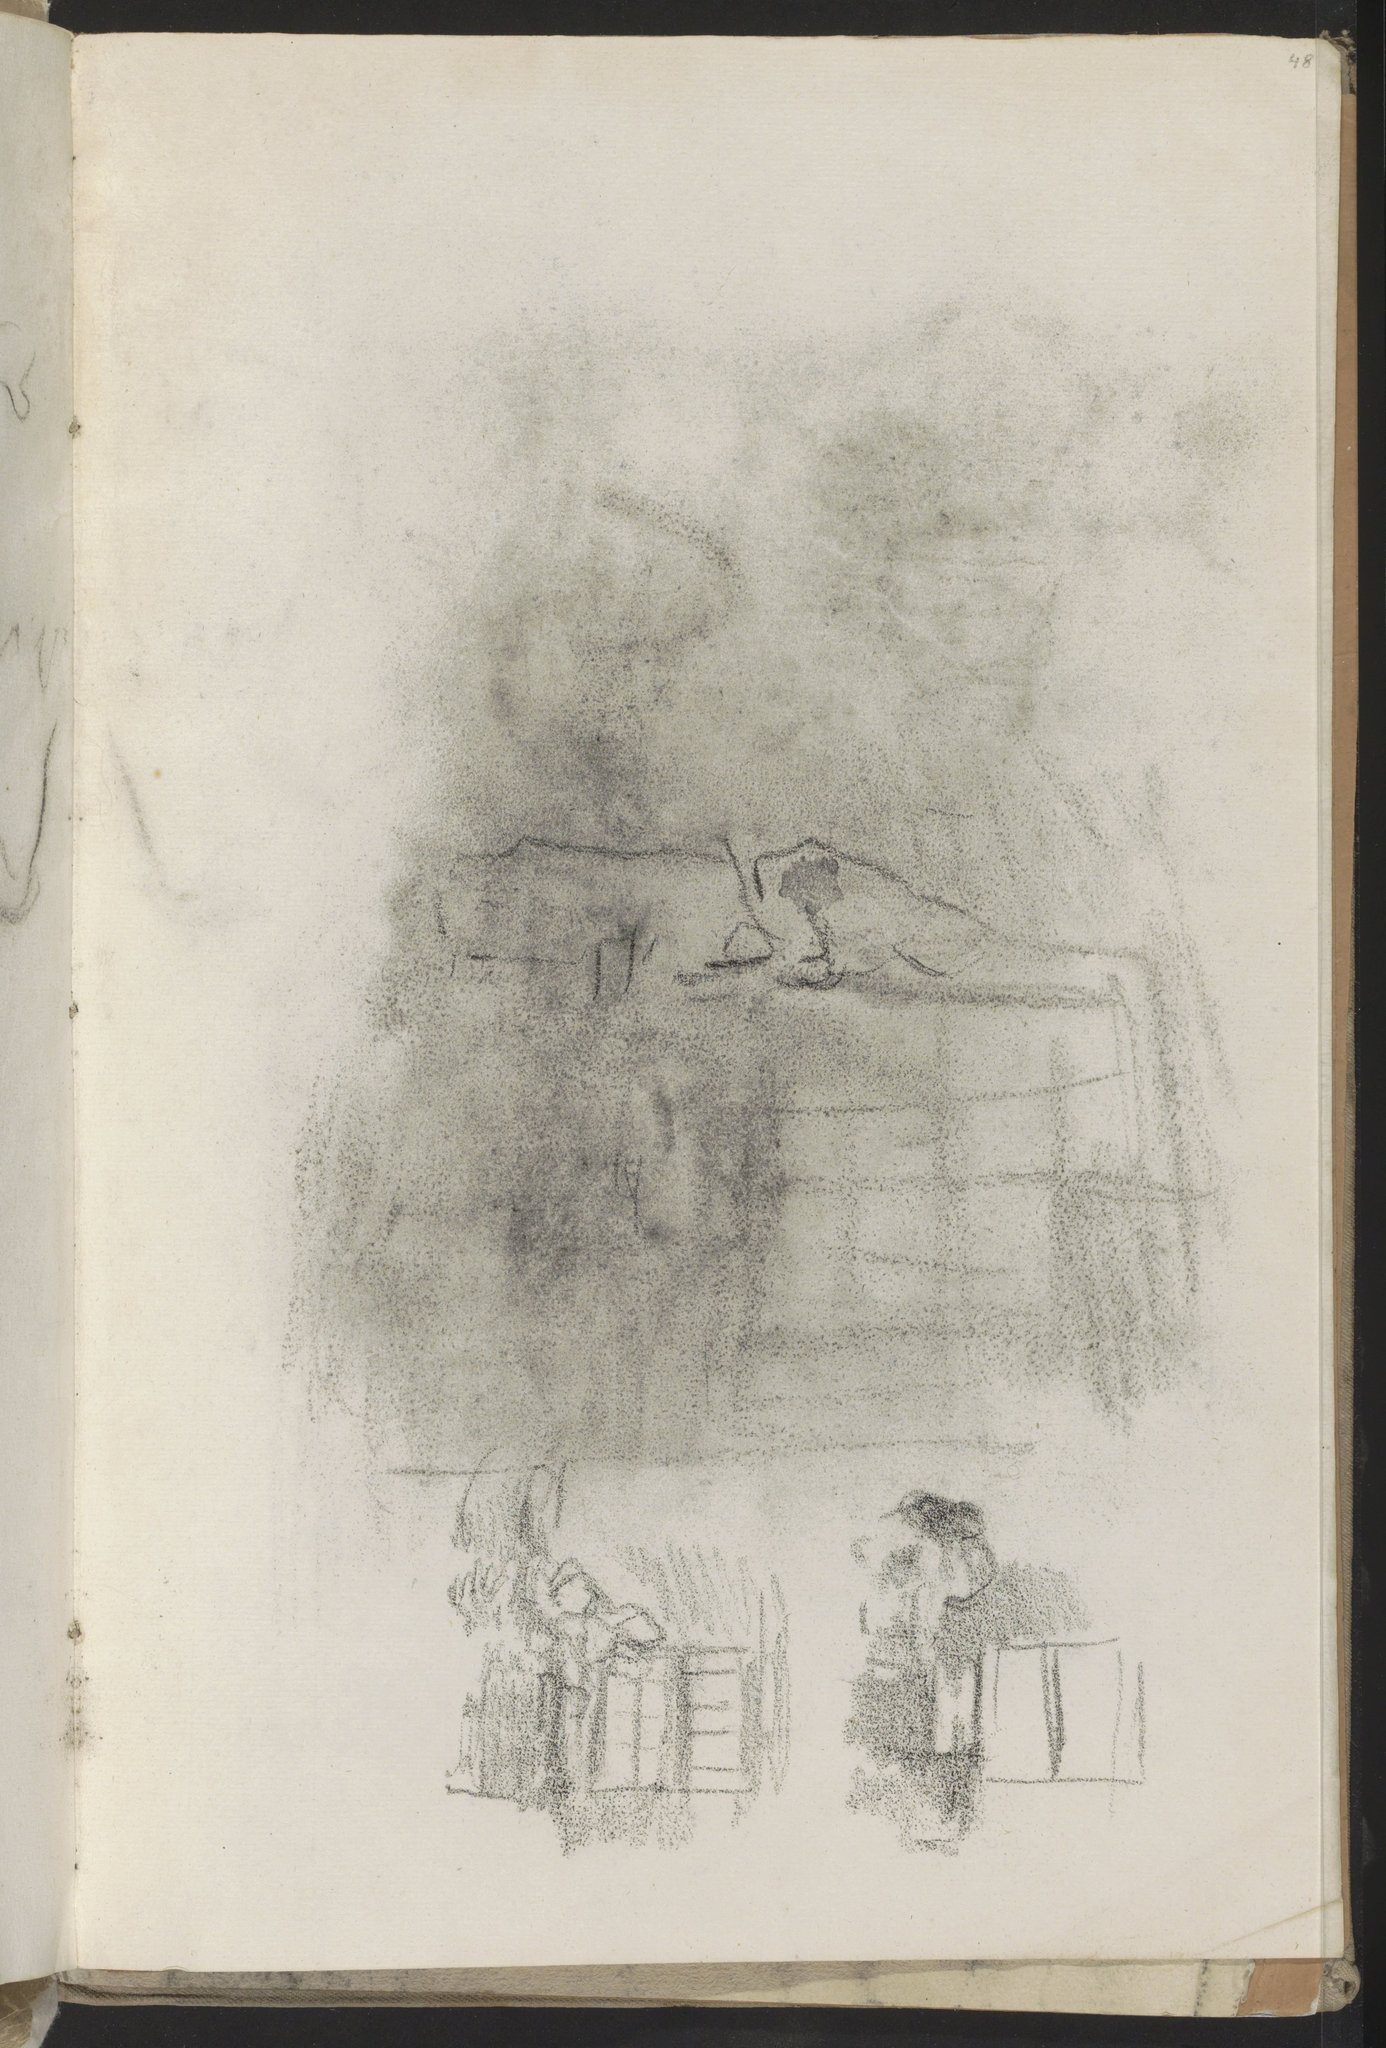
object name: sketchbook leaf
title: Handwerkende figuur bij een venster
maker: albert neuhuys (1844-1914)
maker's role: draughtsman, painter, print maker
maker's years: 1844-1914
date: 1854-1914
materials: charcoal, paper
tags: standing figure, window, interior of the house, home sewing; repair of clothes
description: Tevens twee studies van vensters. Blad 48 recto uit een schetsboek met 53 bladen.